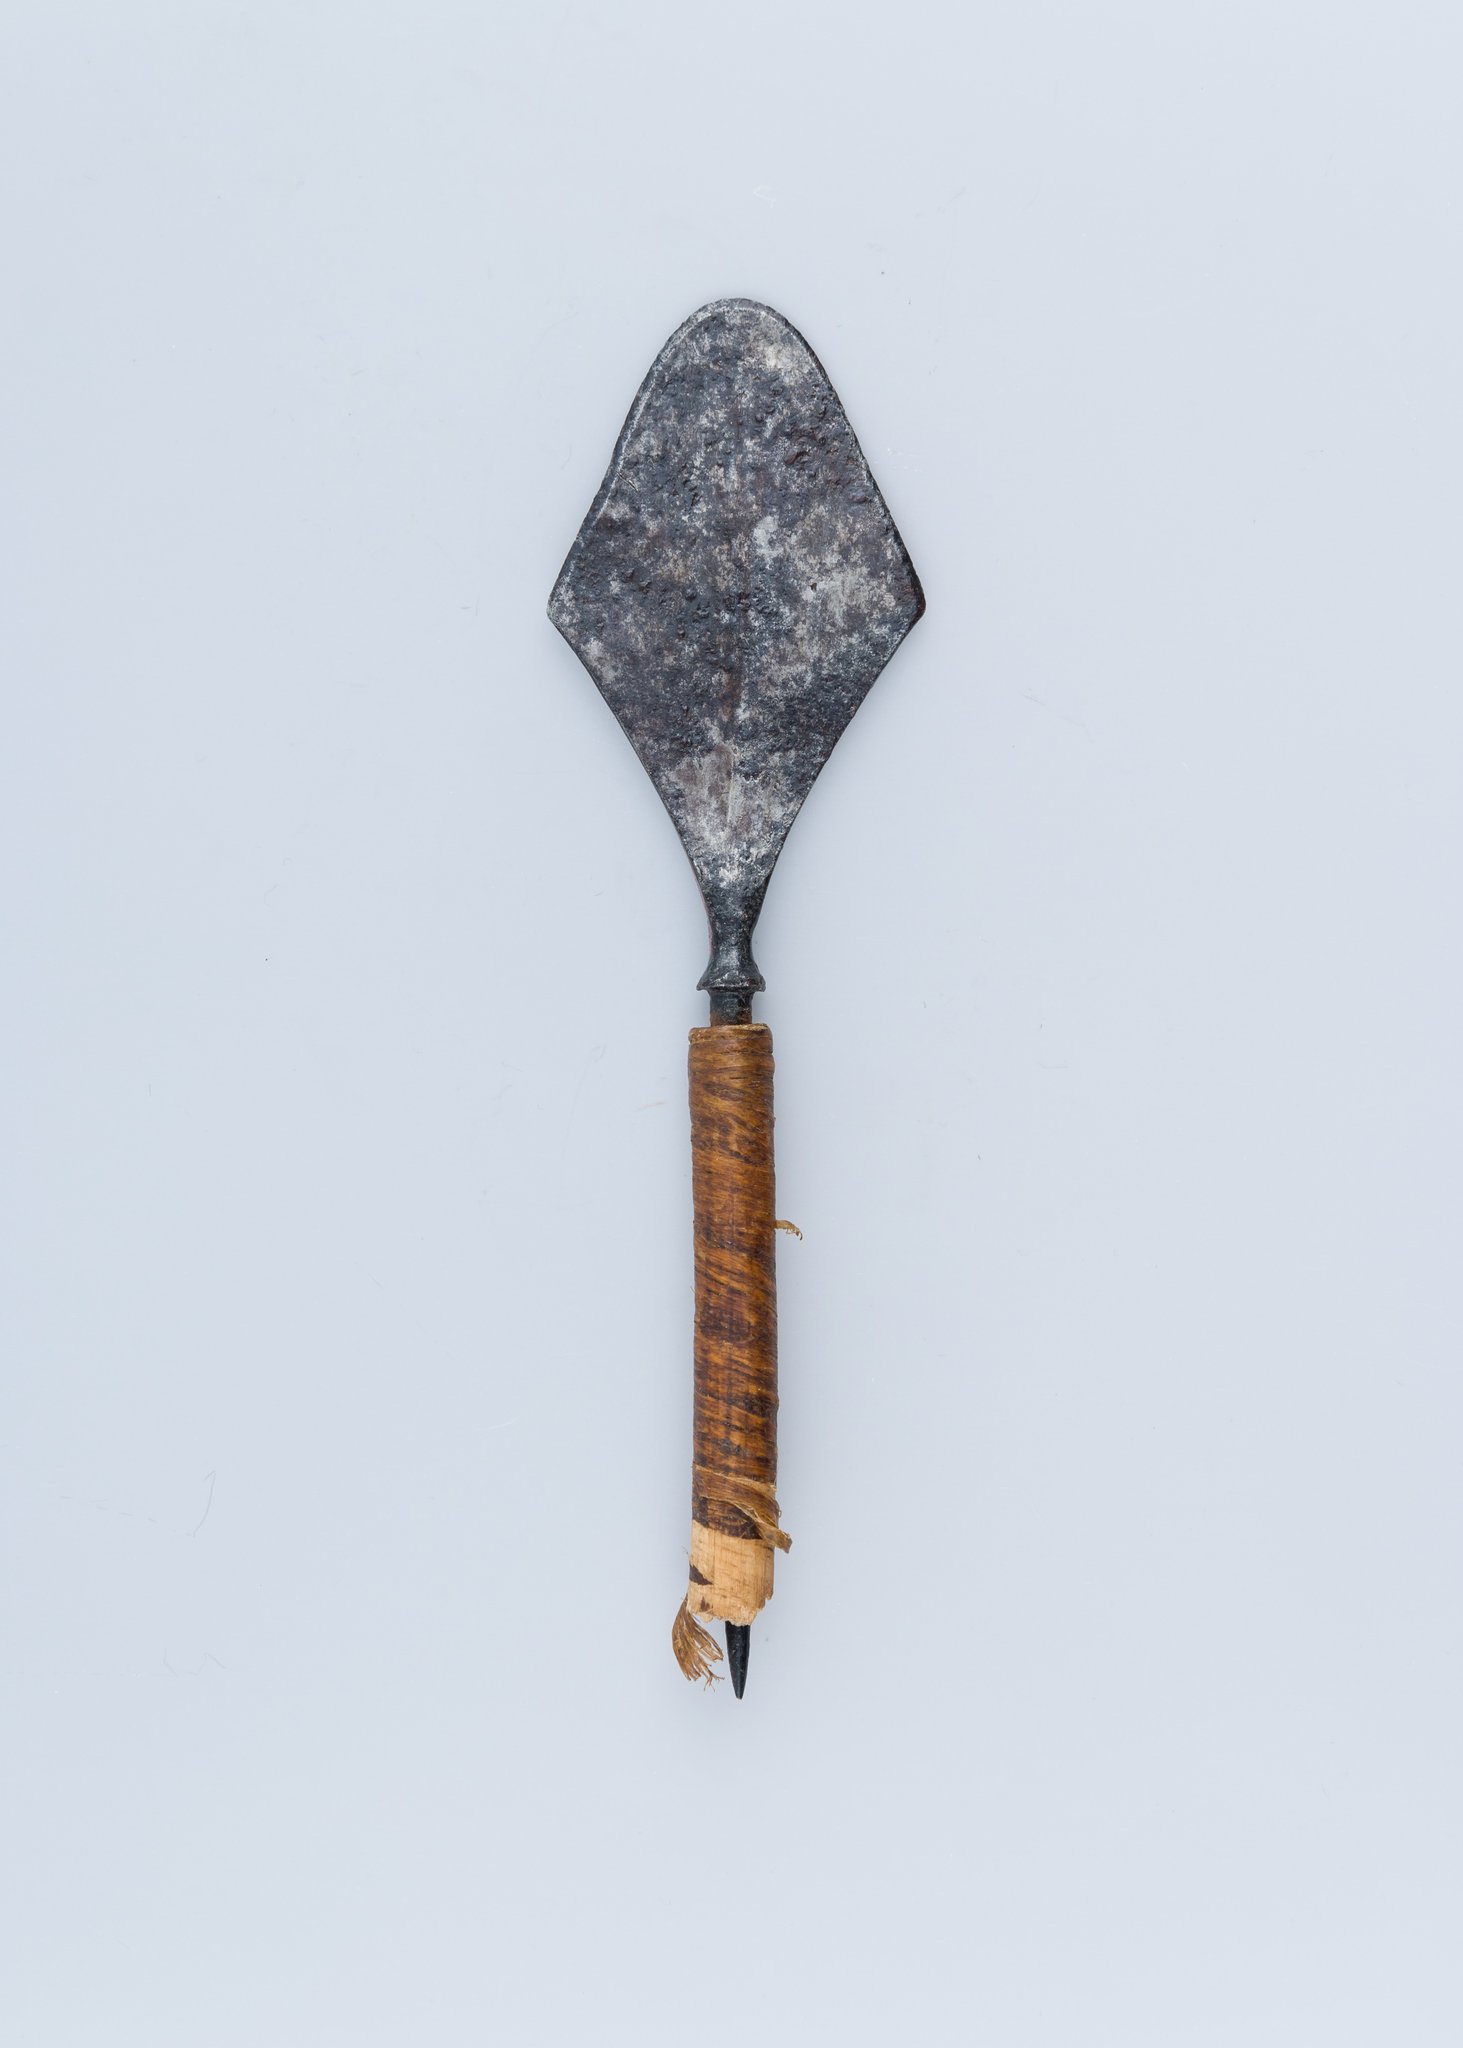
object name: arrowhead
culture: tibetan or chinese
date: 1701-1900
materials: iron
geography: china